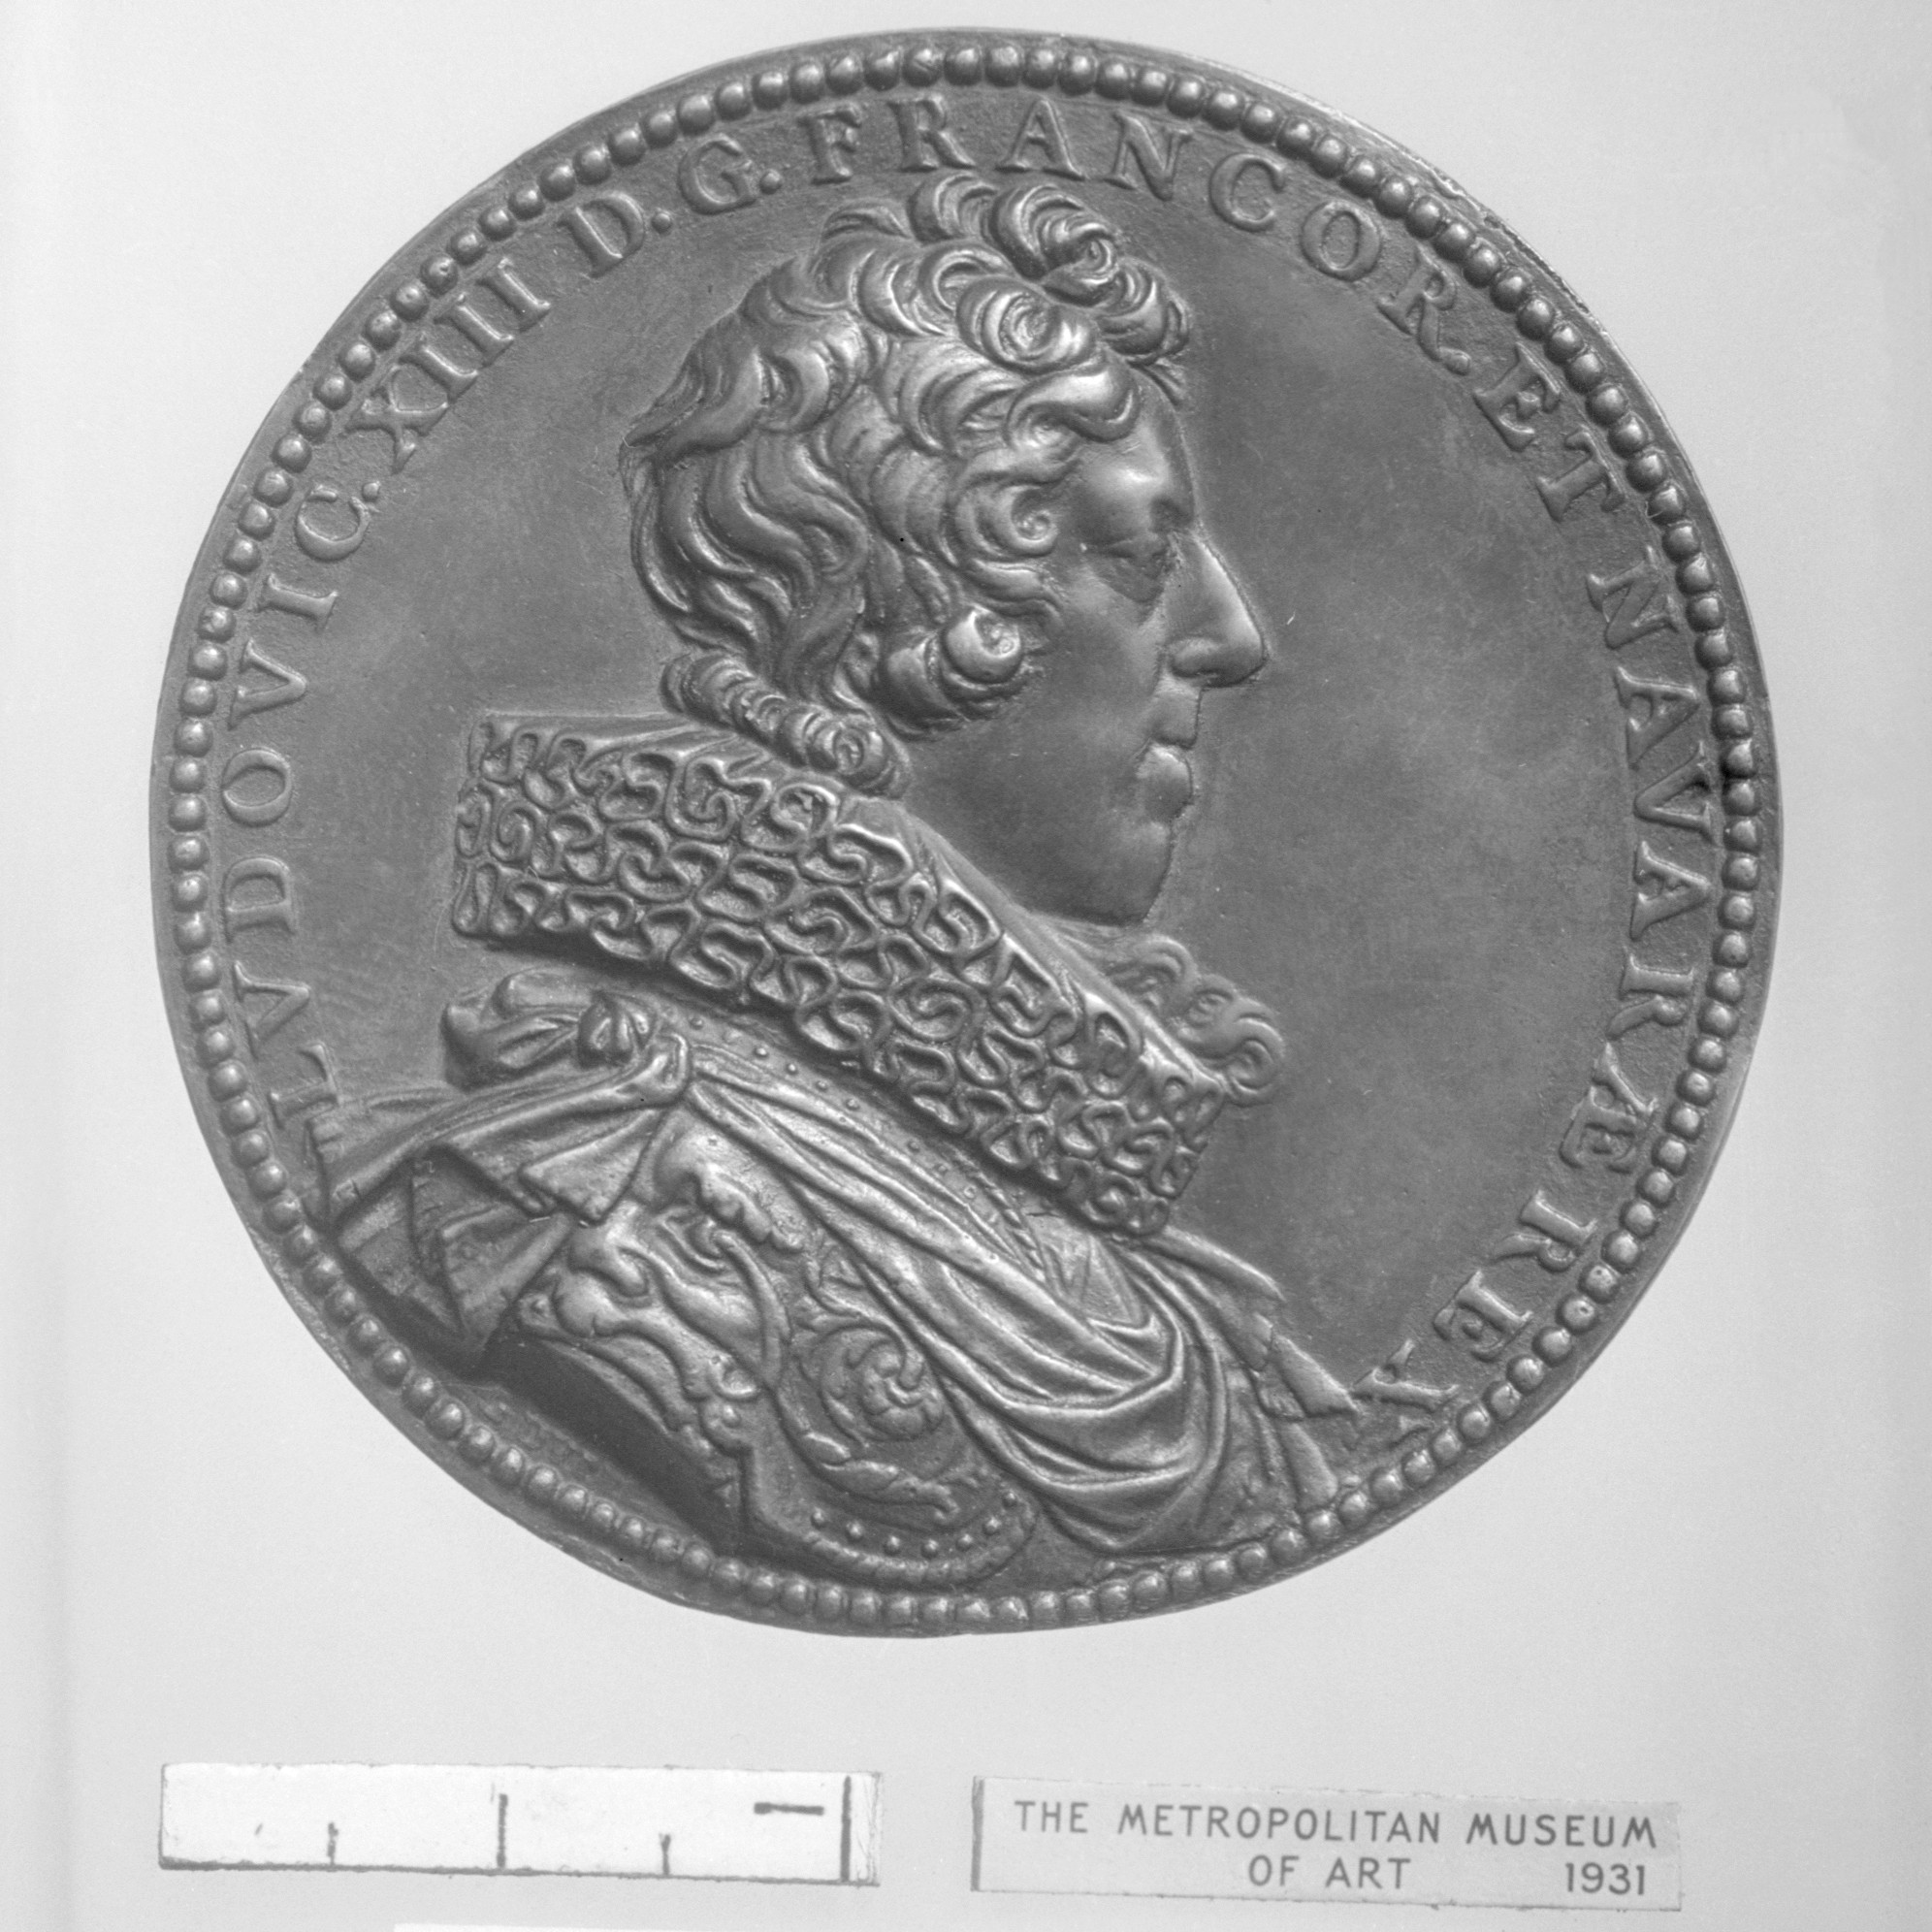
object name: medal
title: Louis XIII, King of France (b. 1601, r. 1610–43)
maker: guillaume dupré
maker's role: artist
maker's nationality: french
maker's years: 1579-1640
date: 1623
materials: bronze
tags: kings,women